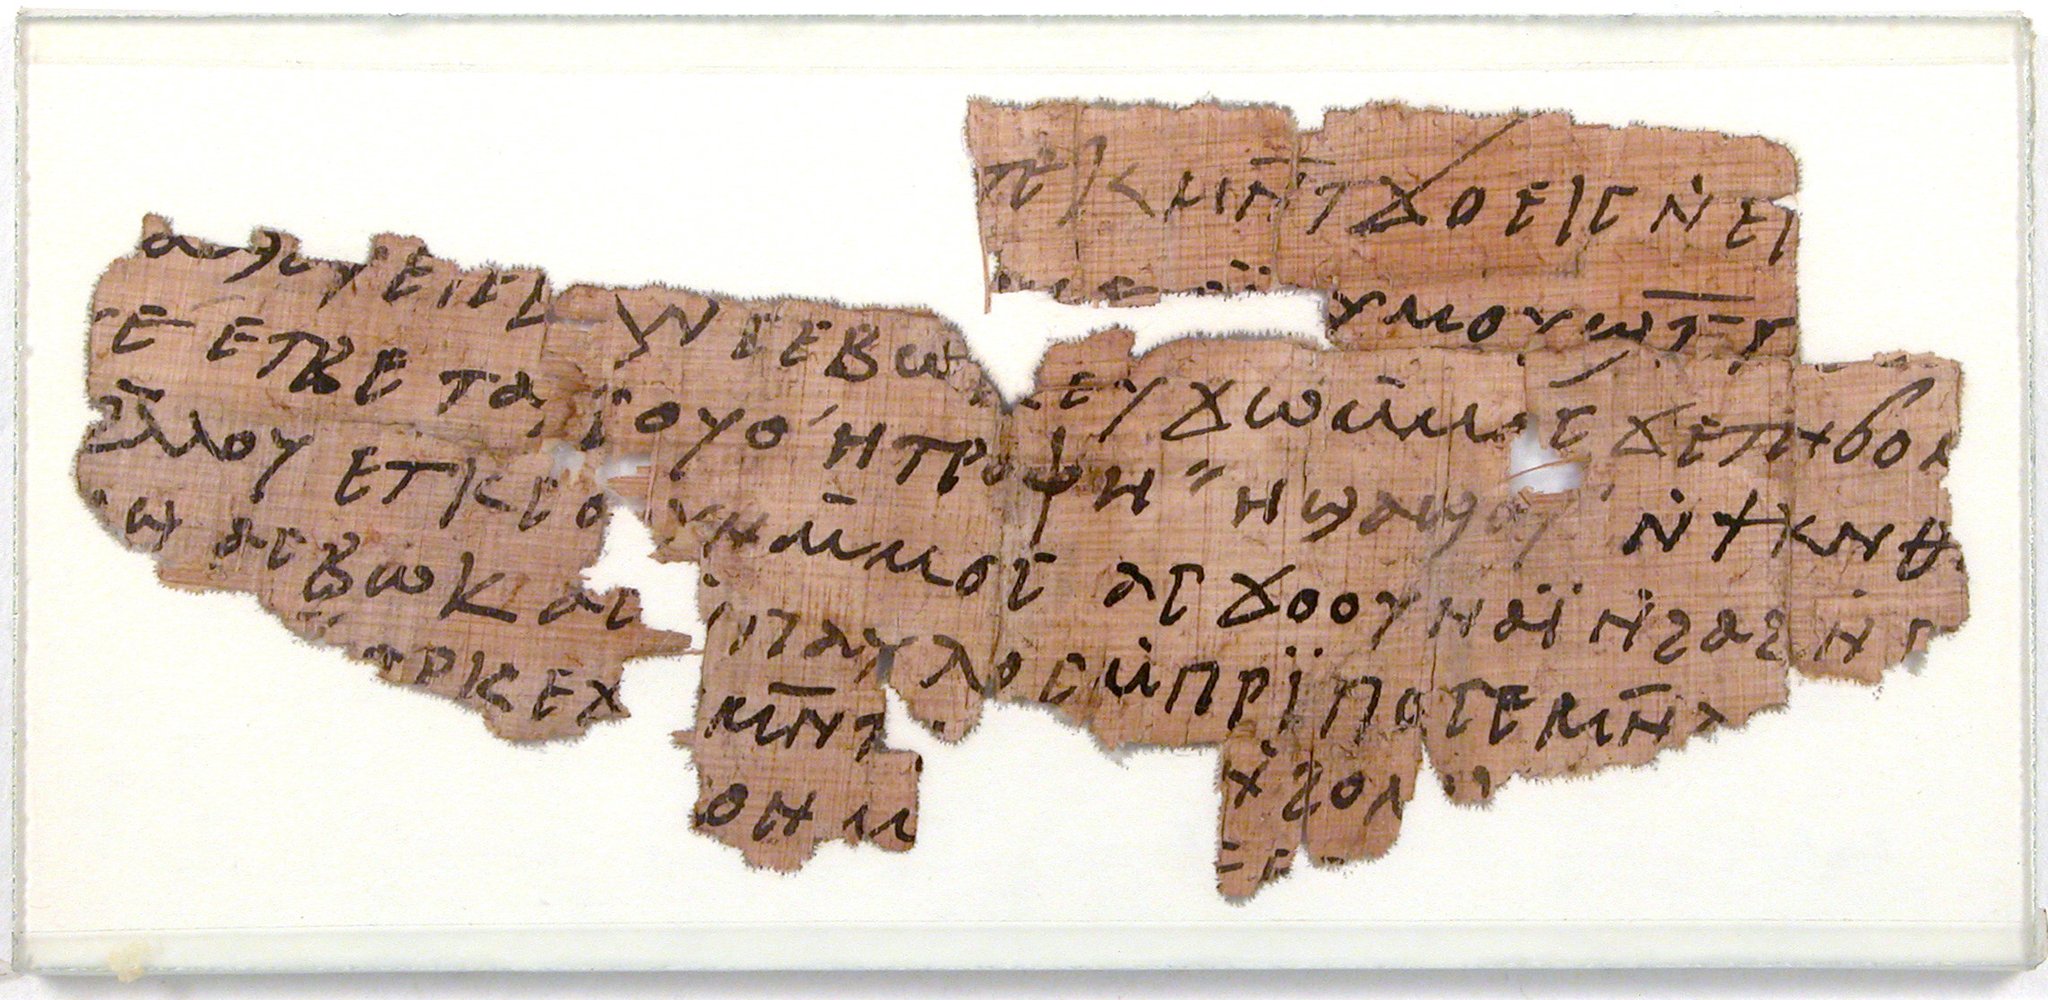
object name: fragment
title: Papyrus Fragments of a Letter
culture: coptic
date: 601-700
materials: ink, papyrus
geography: egypt